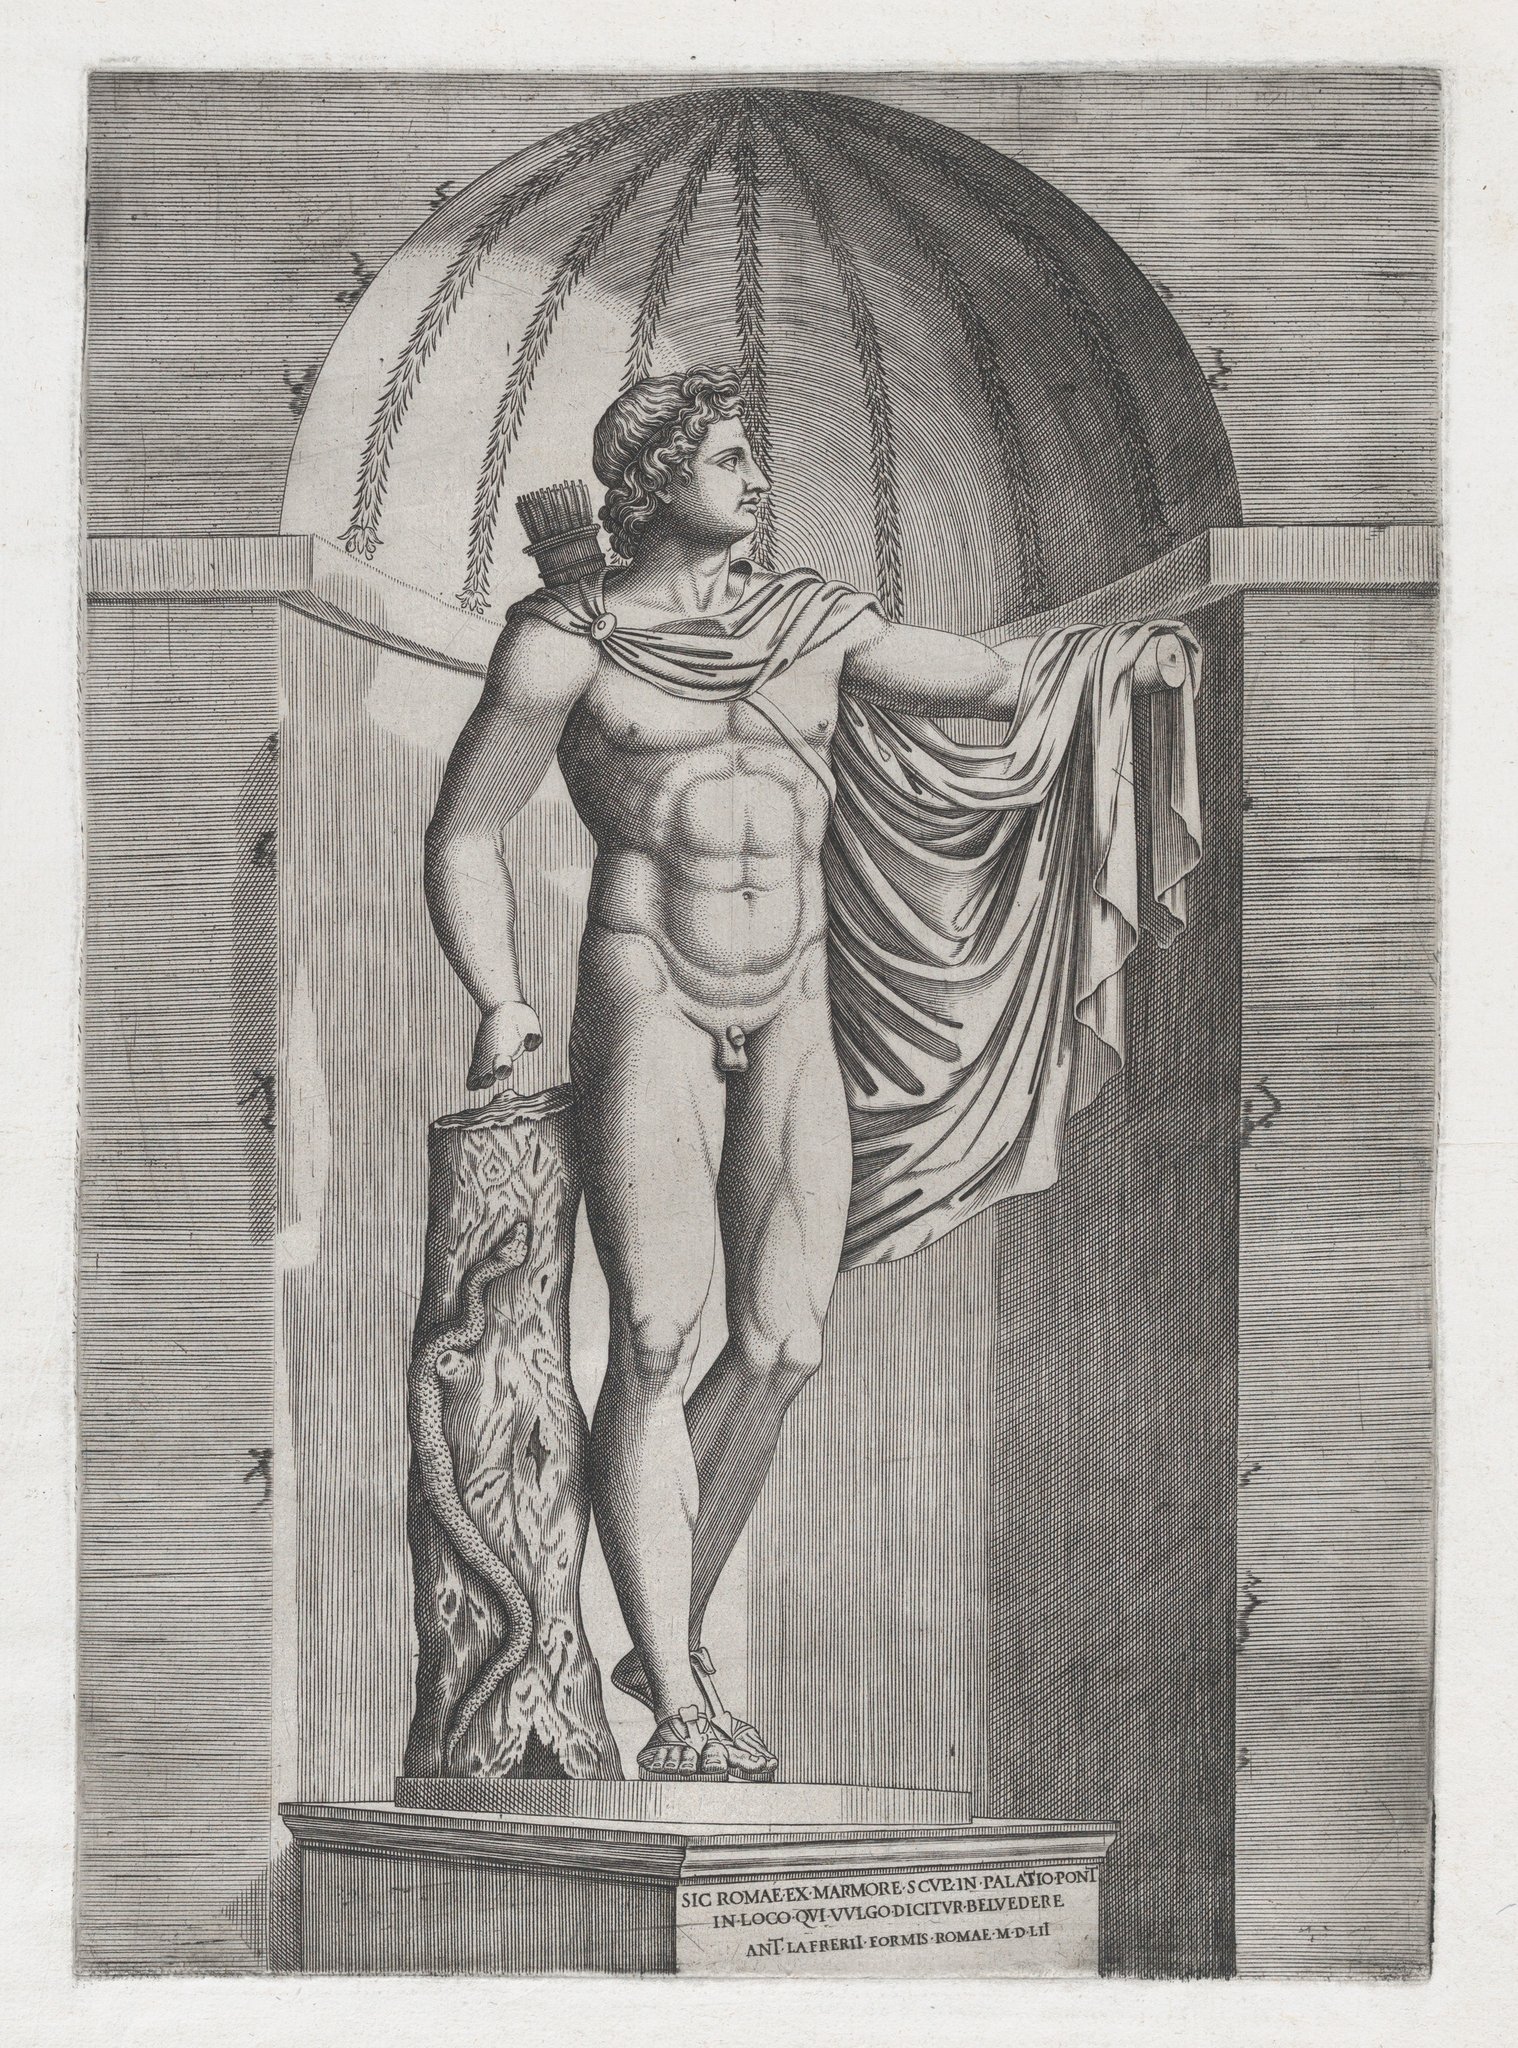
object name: print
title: Apollo Belvedere, from "Speculum Romanae Magnificentiae"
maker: marcantonio raimondi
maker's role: artist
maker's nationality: italian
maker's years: 1475-1534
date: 1552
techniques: engraving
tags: sculpture,apollo,snakes